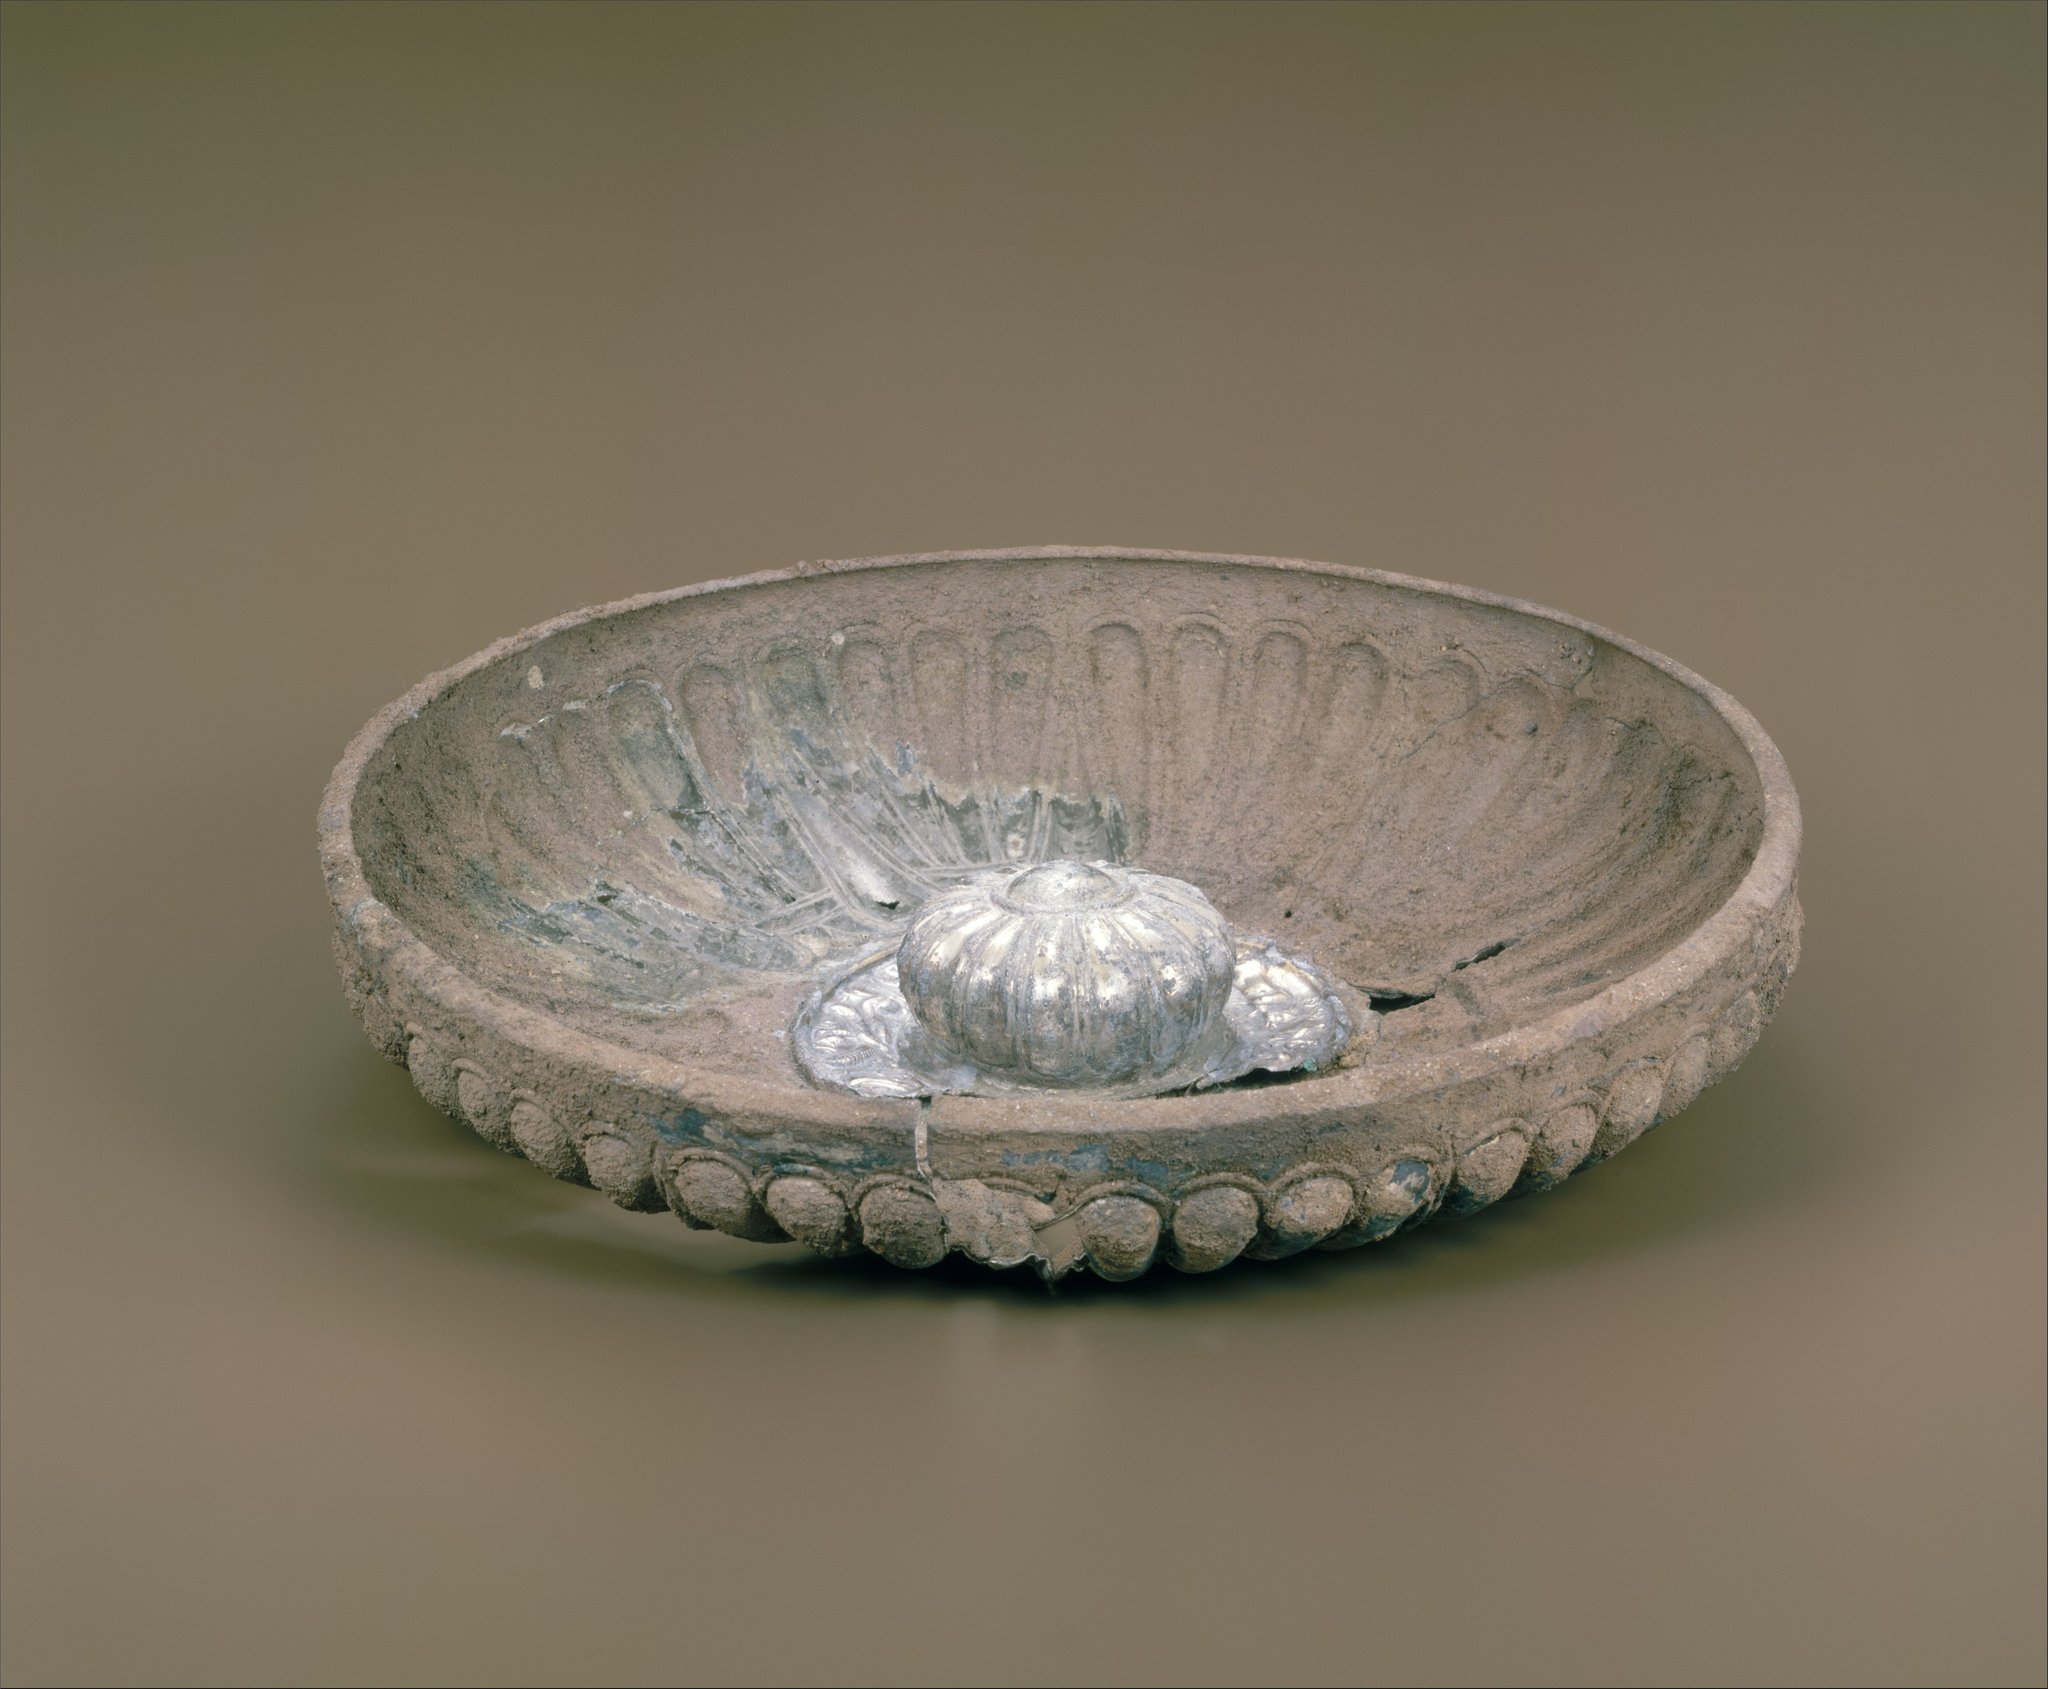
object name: phiale with gilding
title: Silver phiale (libation bowl)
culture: east greek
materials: gold, silver